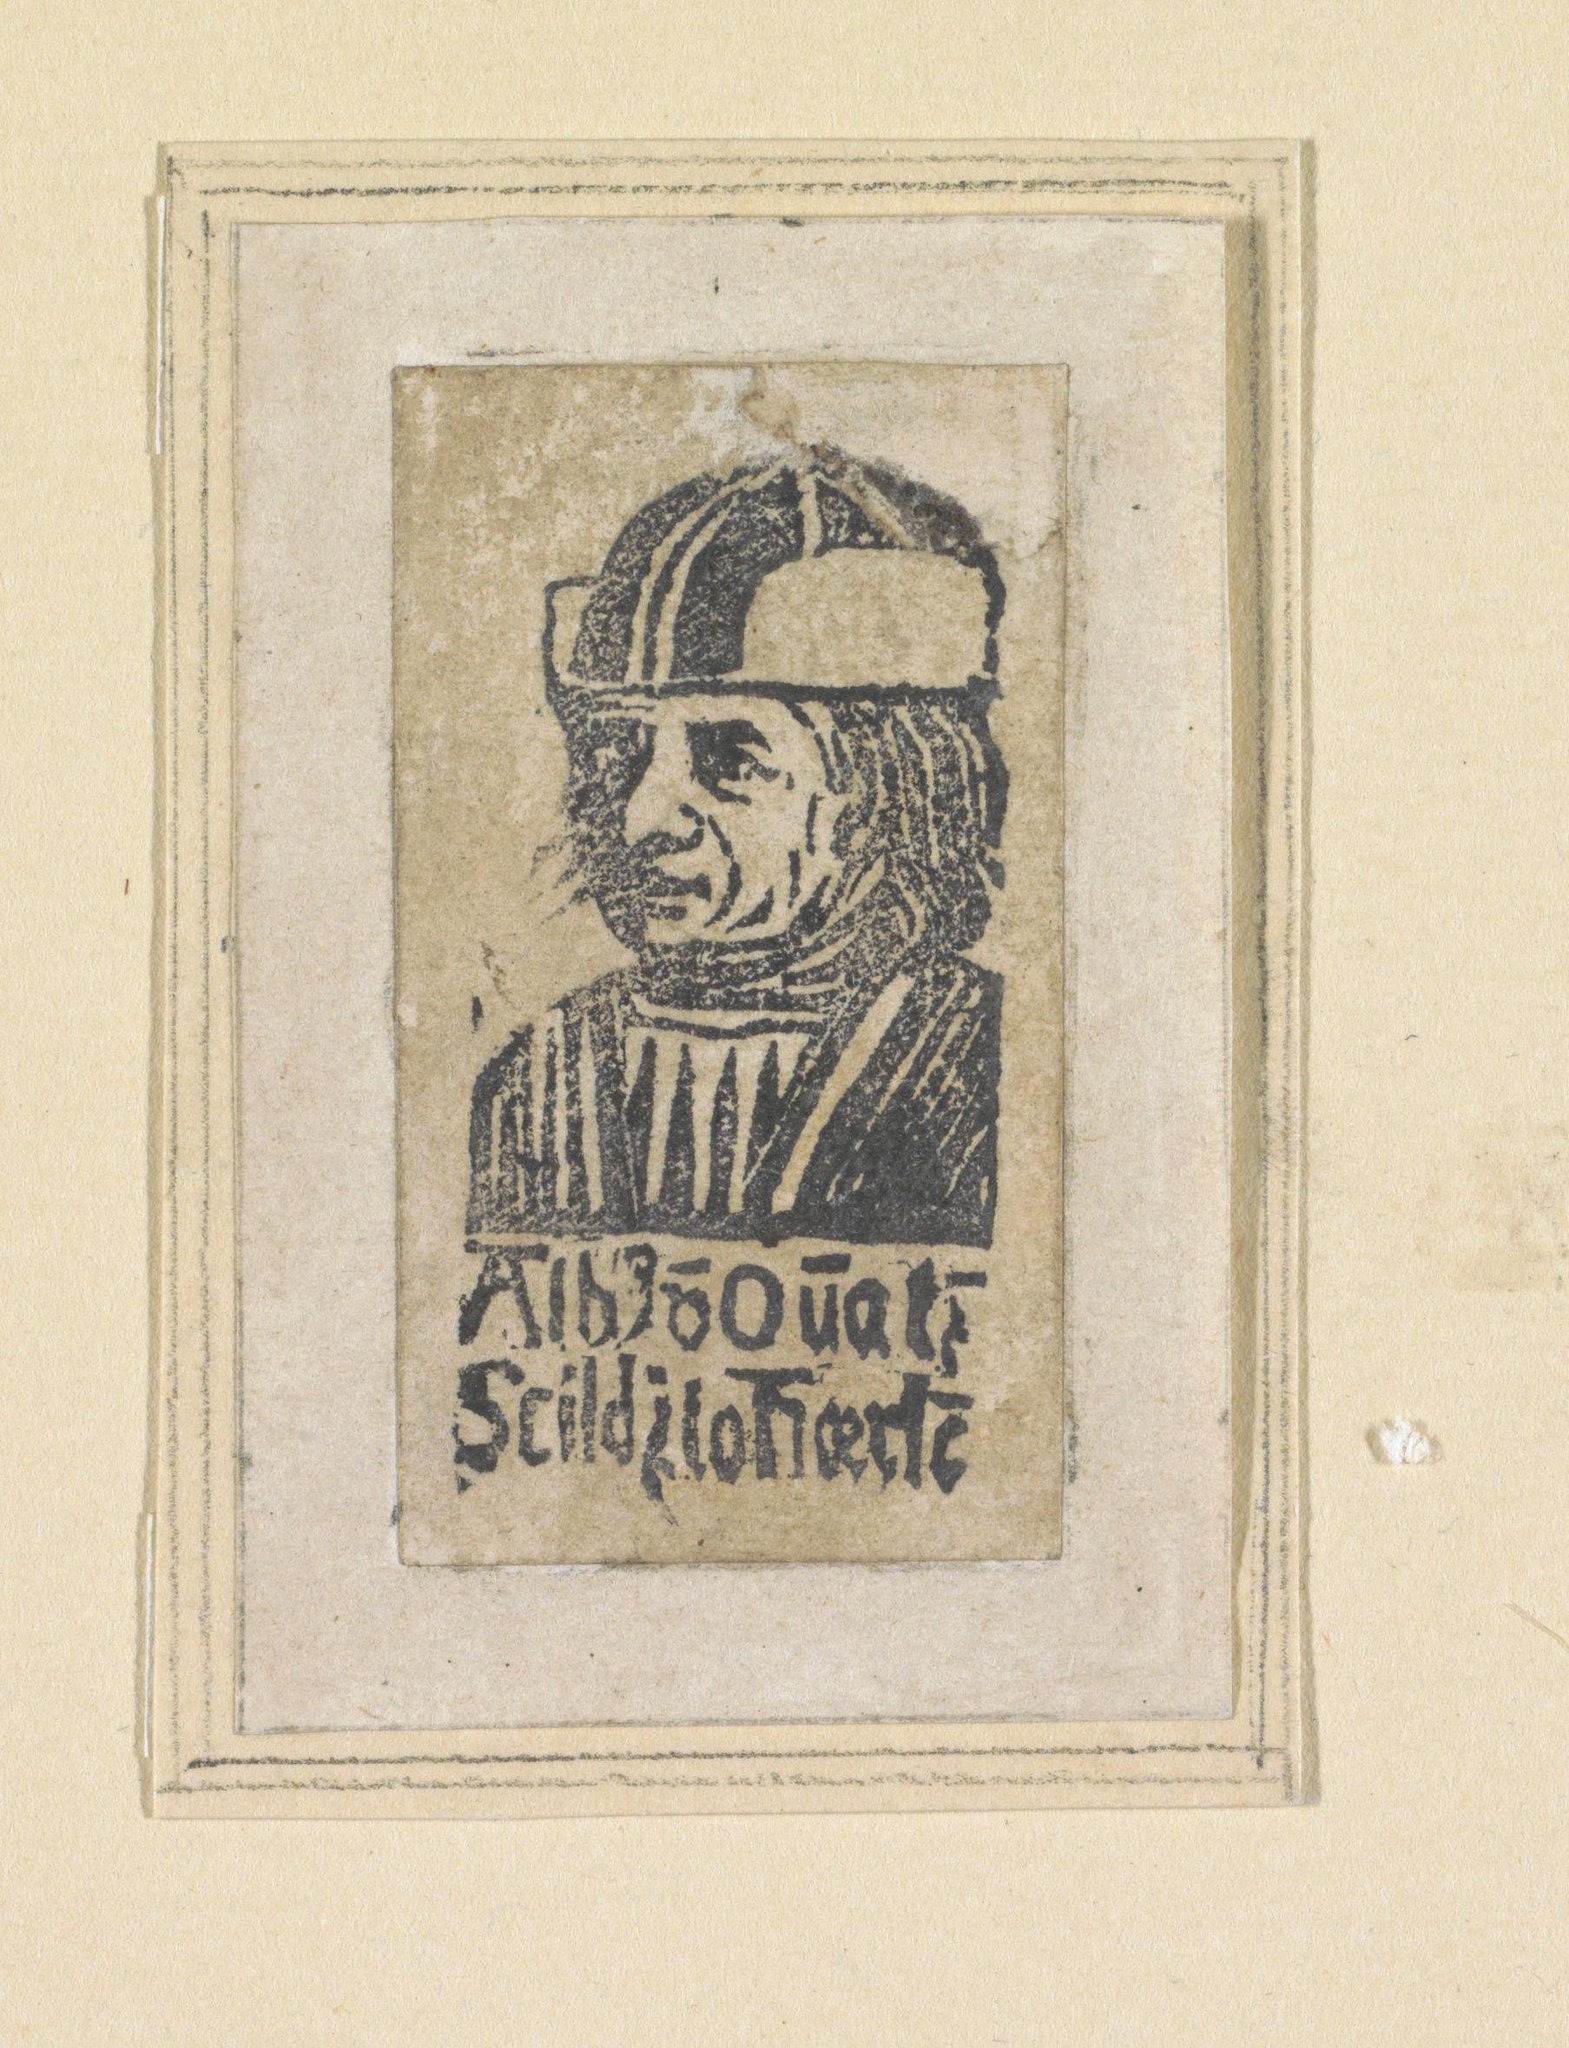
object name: print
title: Portret van Albert van Ouwater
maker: cornelis van den berg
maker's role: draughtsman, print maker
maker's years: 1699-1774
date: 1720-1774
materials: paper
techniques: woodcut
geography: haarlem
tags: painter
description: Portret van Albert van Ouwater. In de ondermarge zijn naam en beroep.